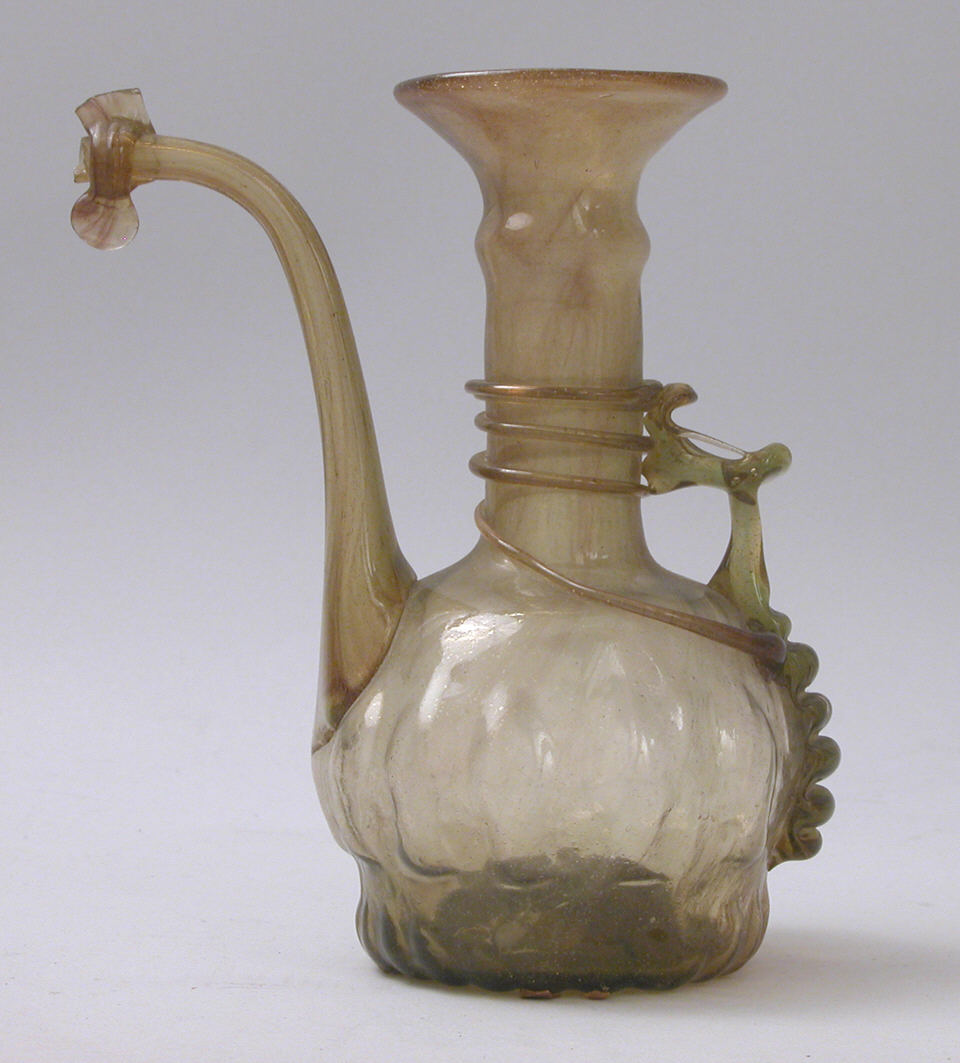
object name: ewer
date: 1701-1900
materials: glass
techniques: glassblowing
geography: iran